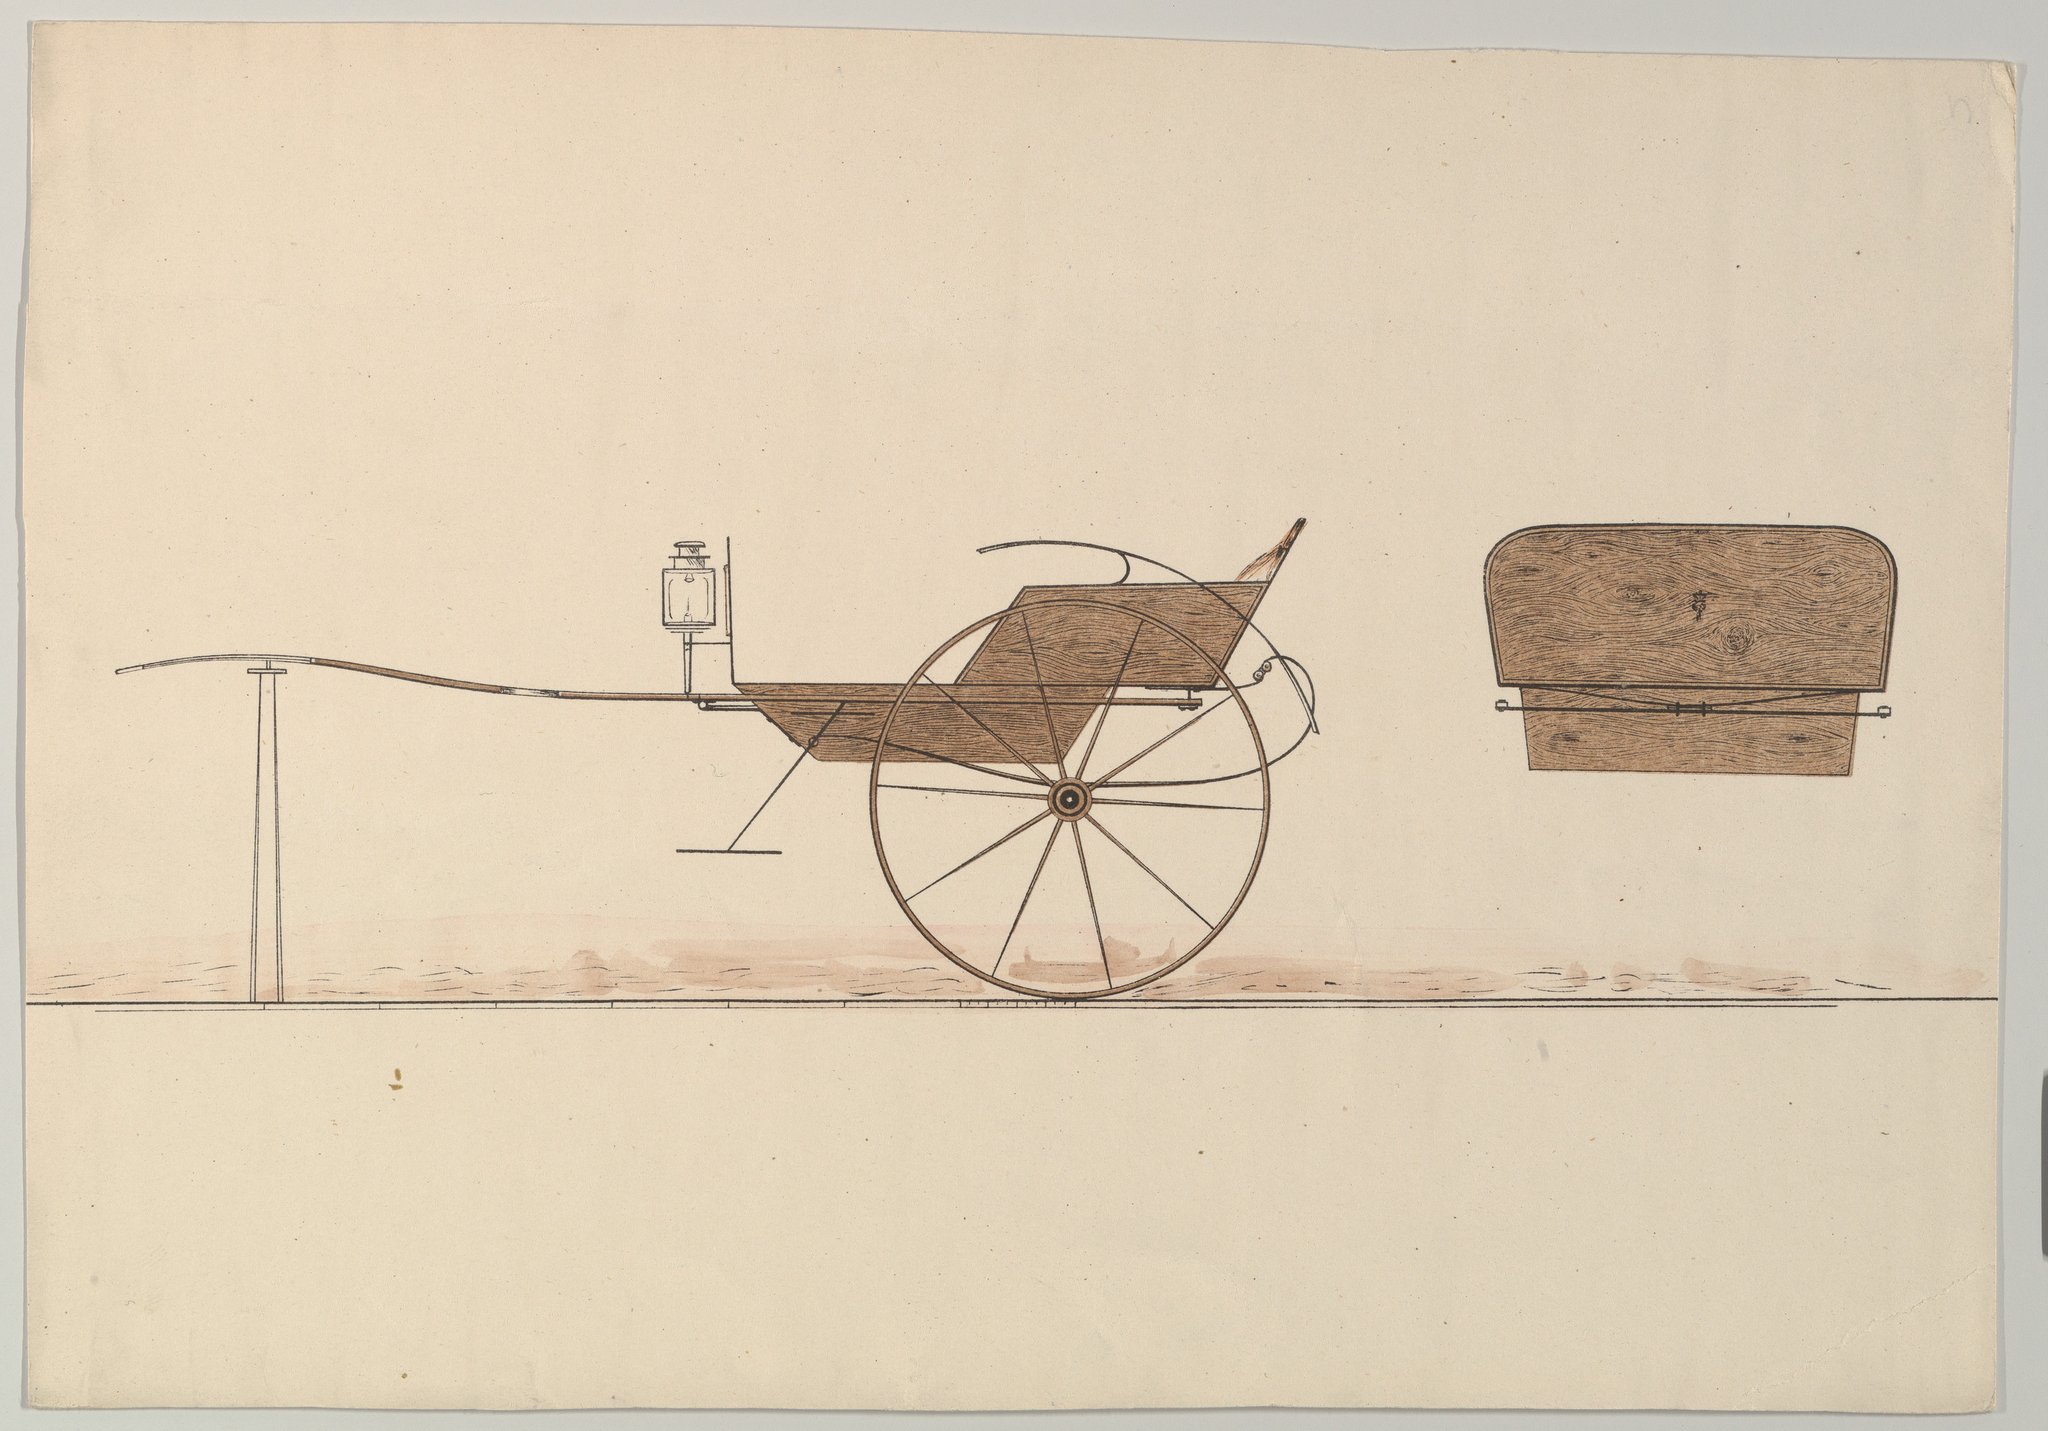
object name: print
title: Village Cart (unnumbered)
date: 1850-1874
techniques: engraving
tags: carriages